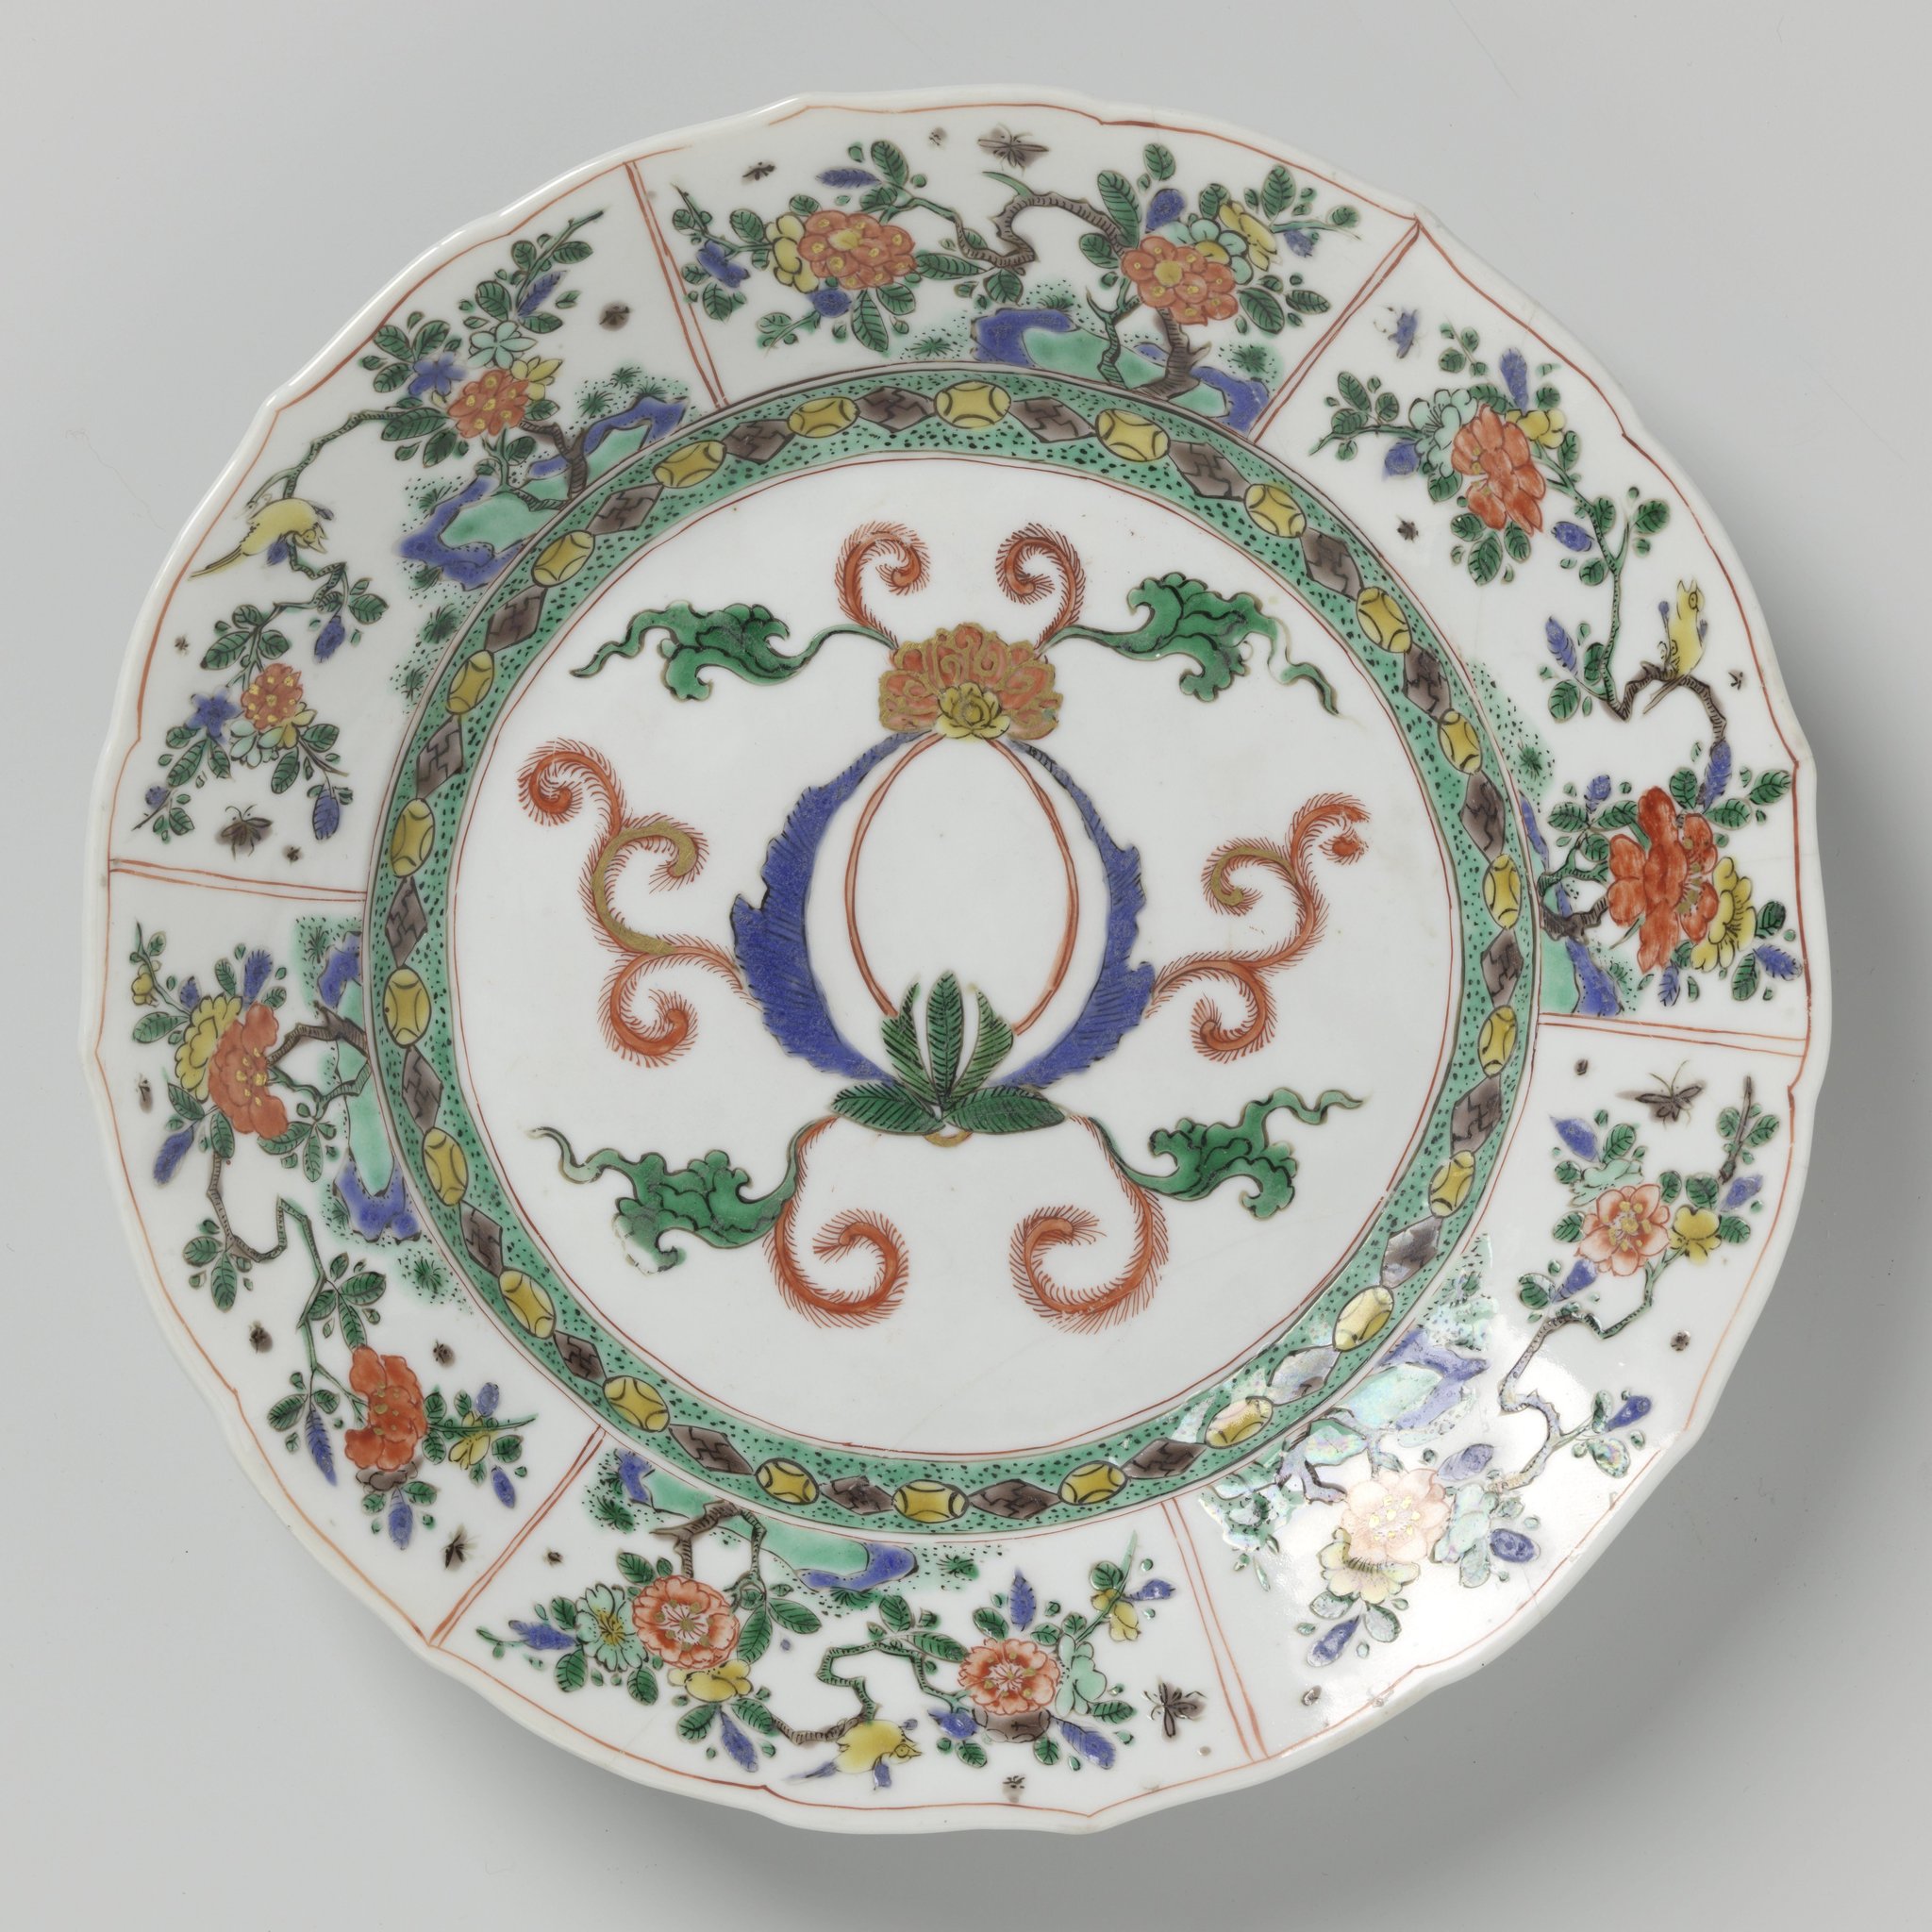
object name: plate dish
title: Plate with foliate scroll decoration and flowering plants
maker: Anonymous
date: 1700-1724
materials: cobalt, glaze, gold, paint, porcelain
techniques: firing, gilding, turning, vitrification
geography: china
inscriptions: mark